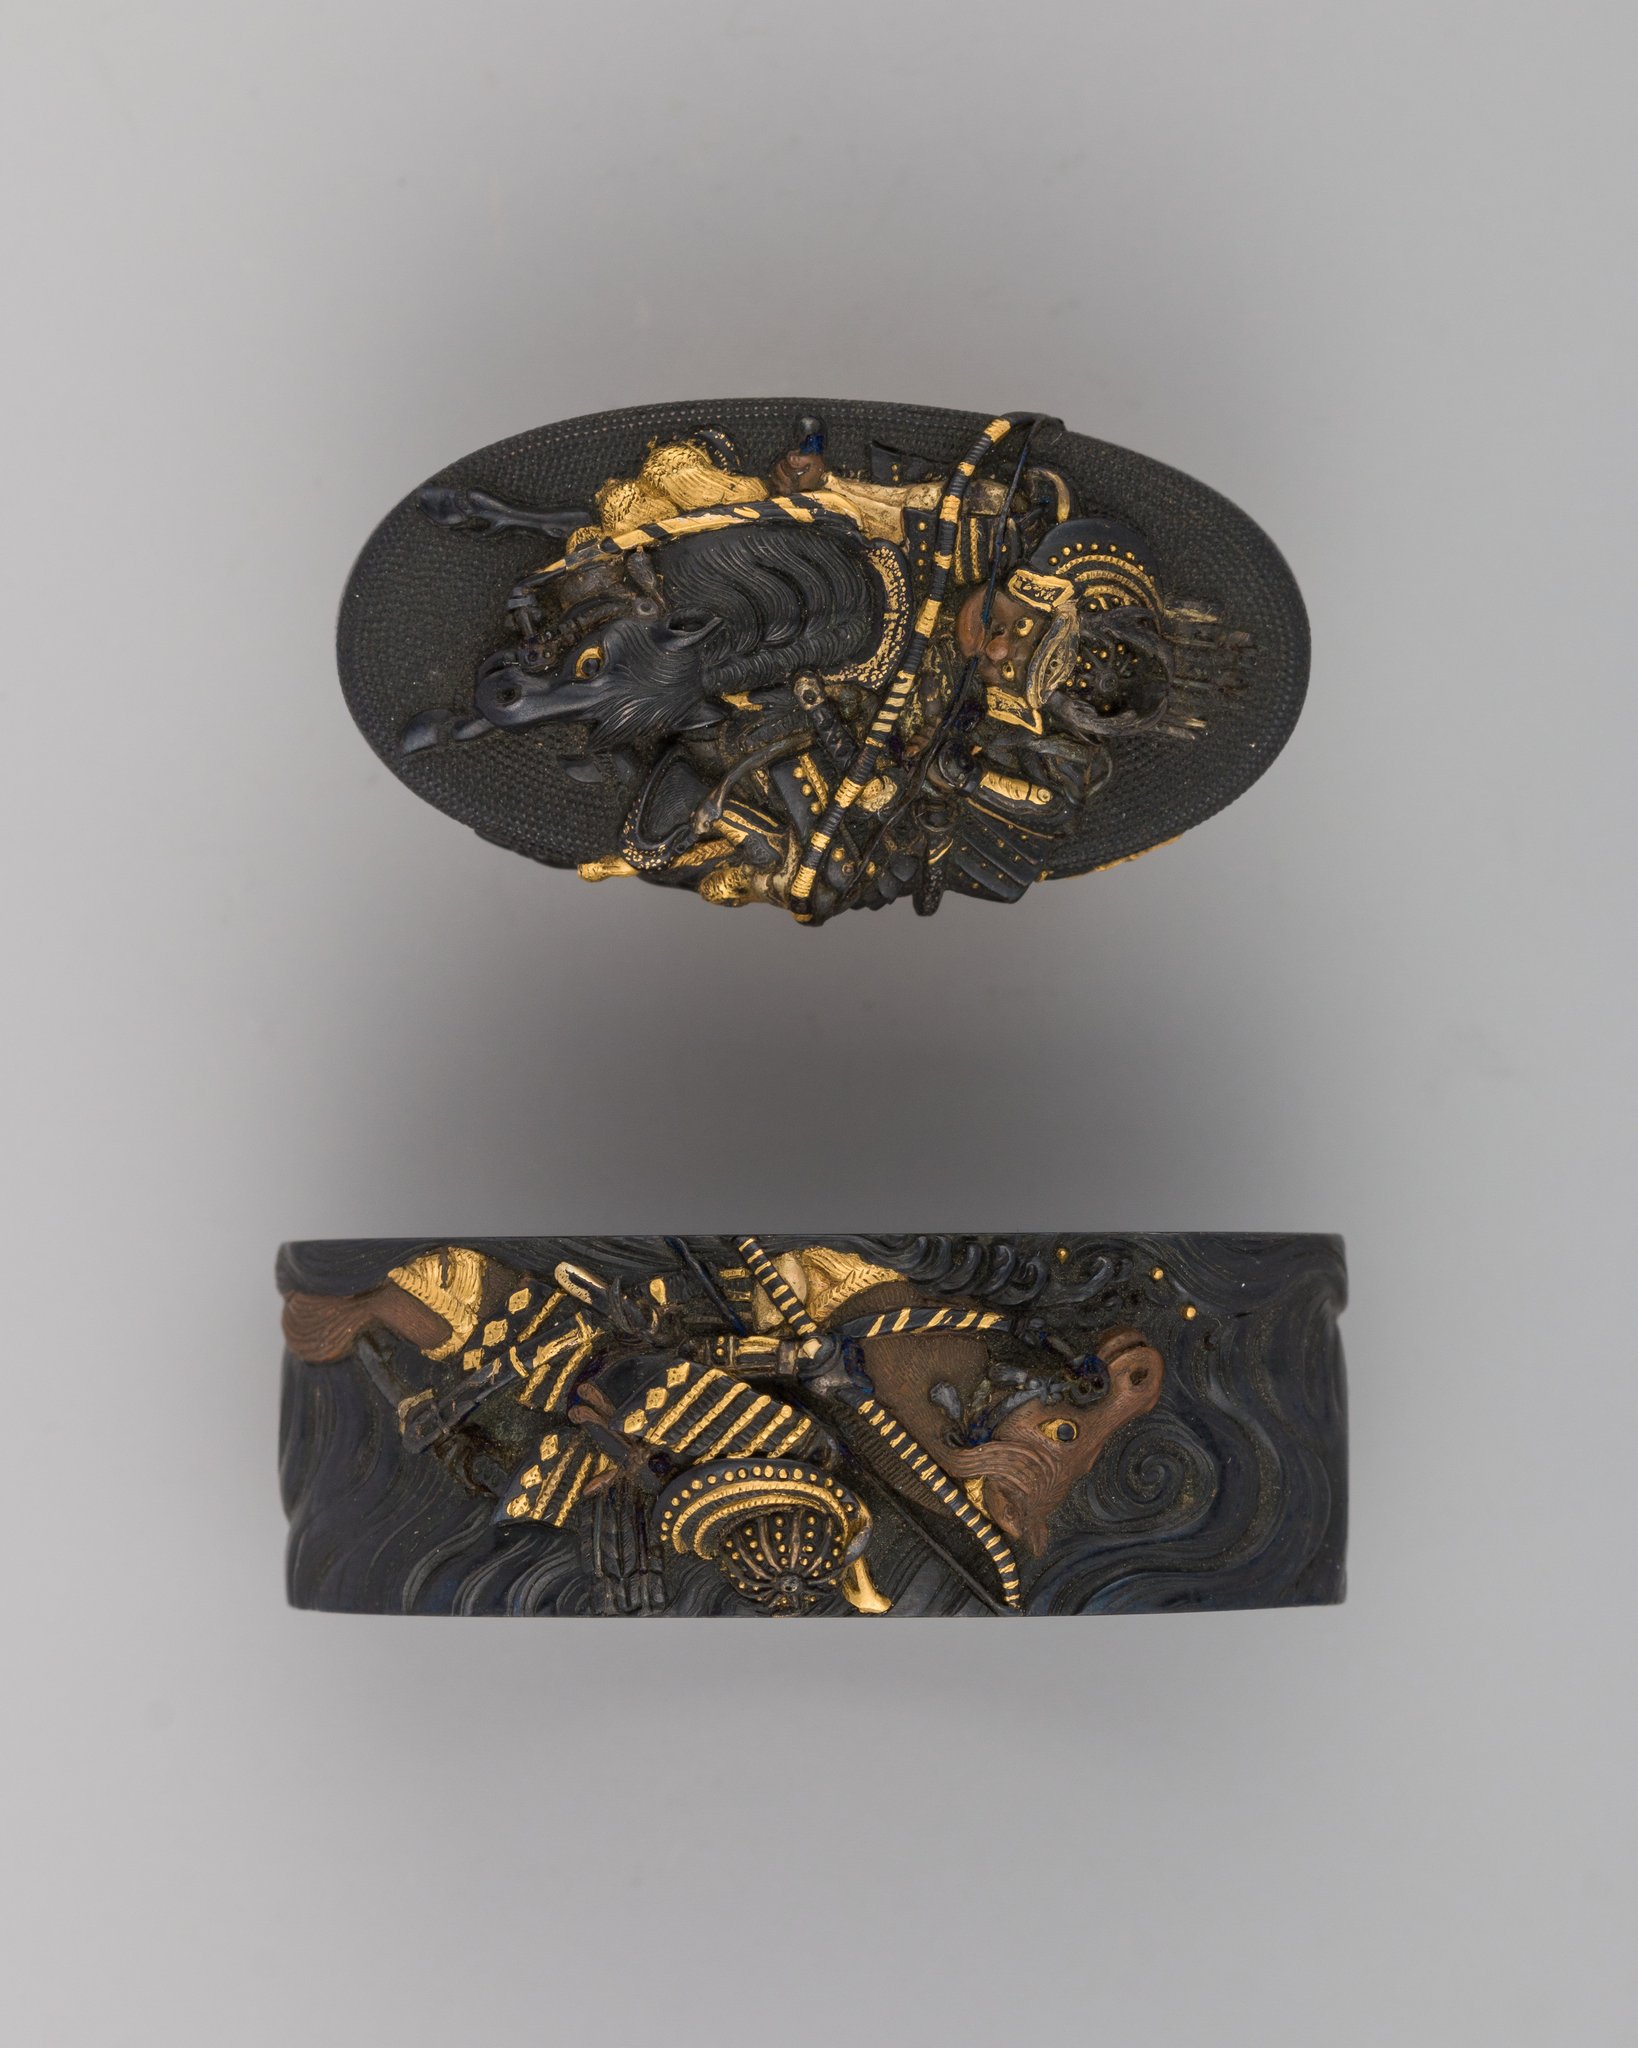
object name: sword hilt collar and pommel fuchigashira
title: Sword-Hilt Collar and Pommel (Fuchigashira)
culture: japanese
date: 1801-1900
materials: copper, gold alloy, silver alloy, gold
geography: japan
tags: human figures,animals,bow and arrow